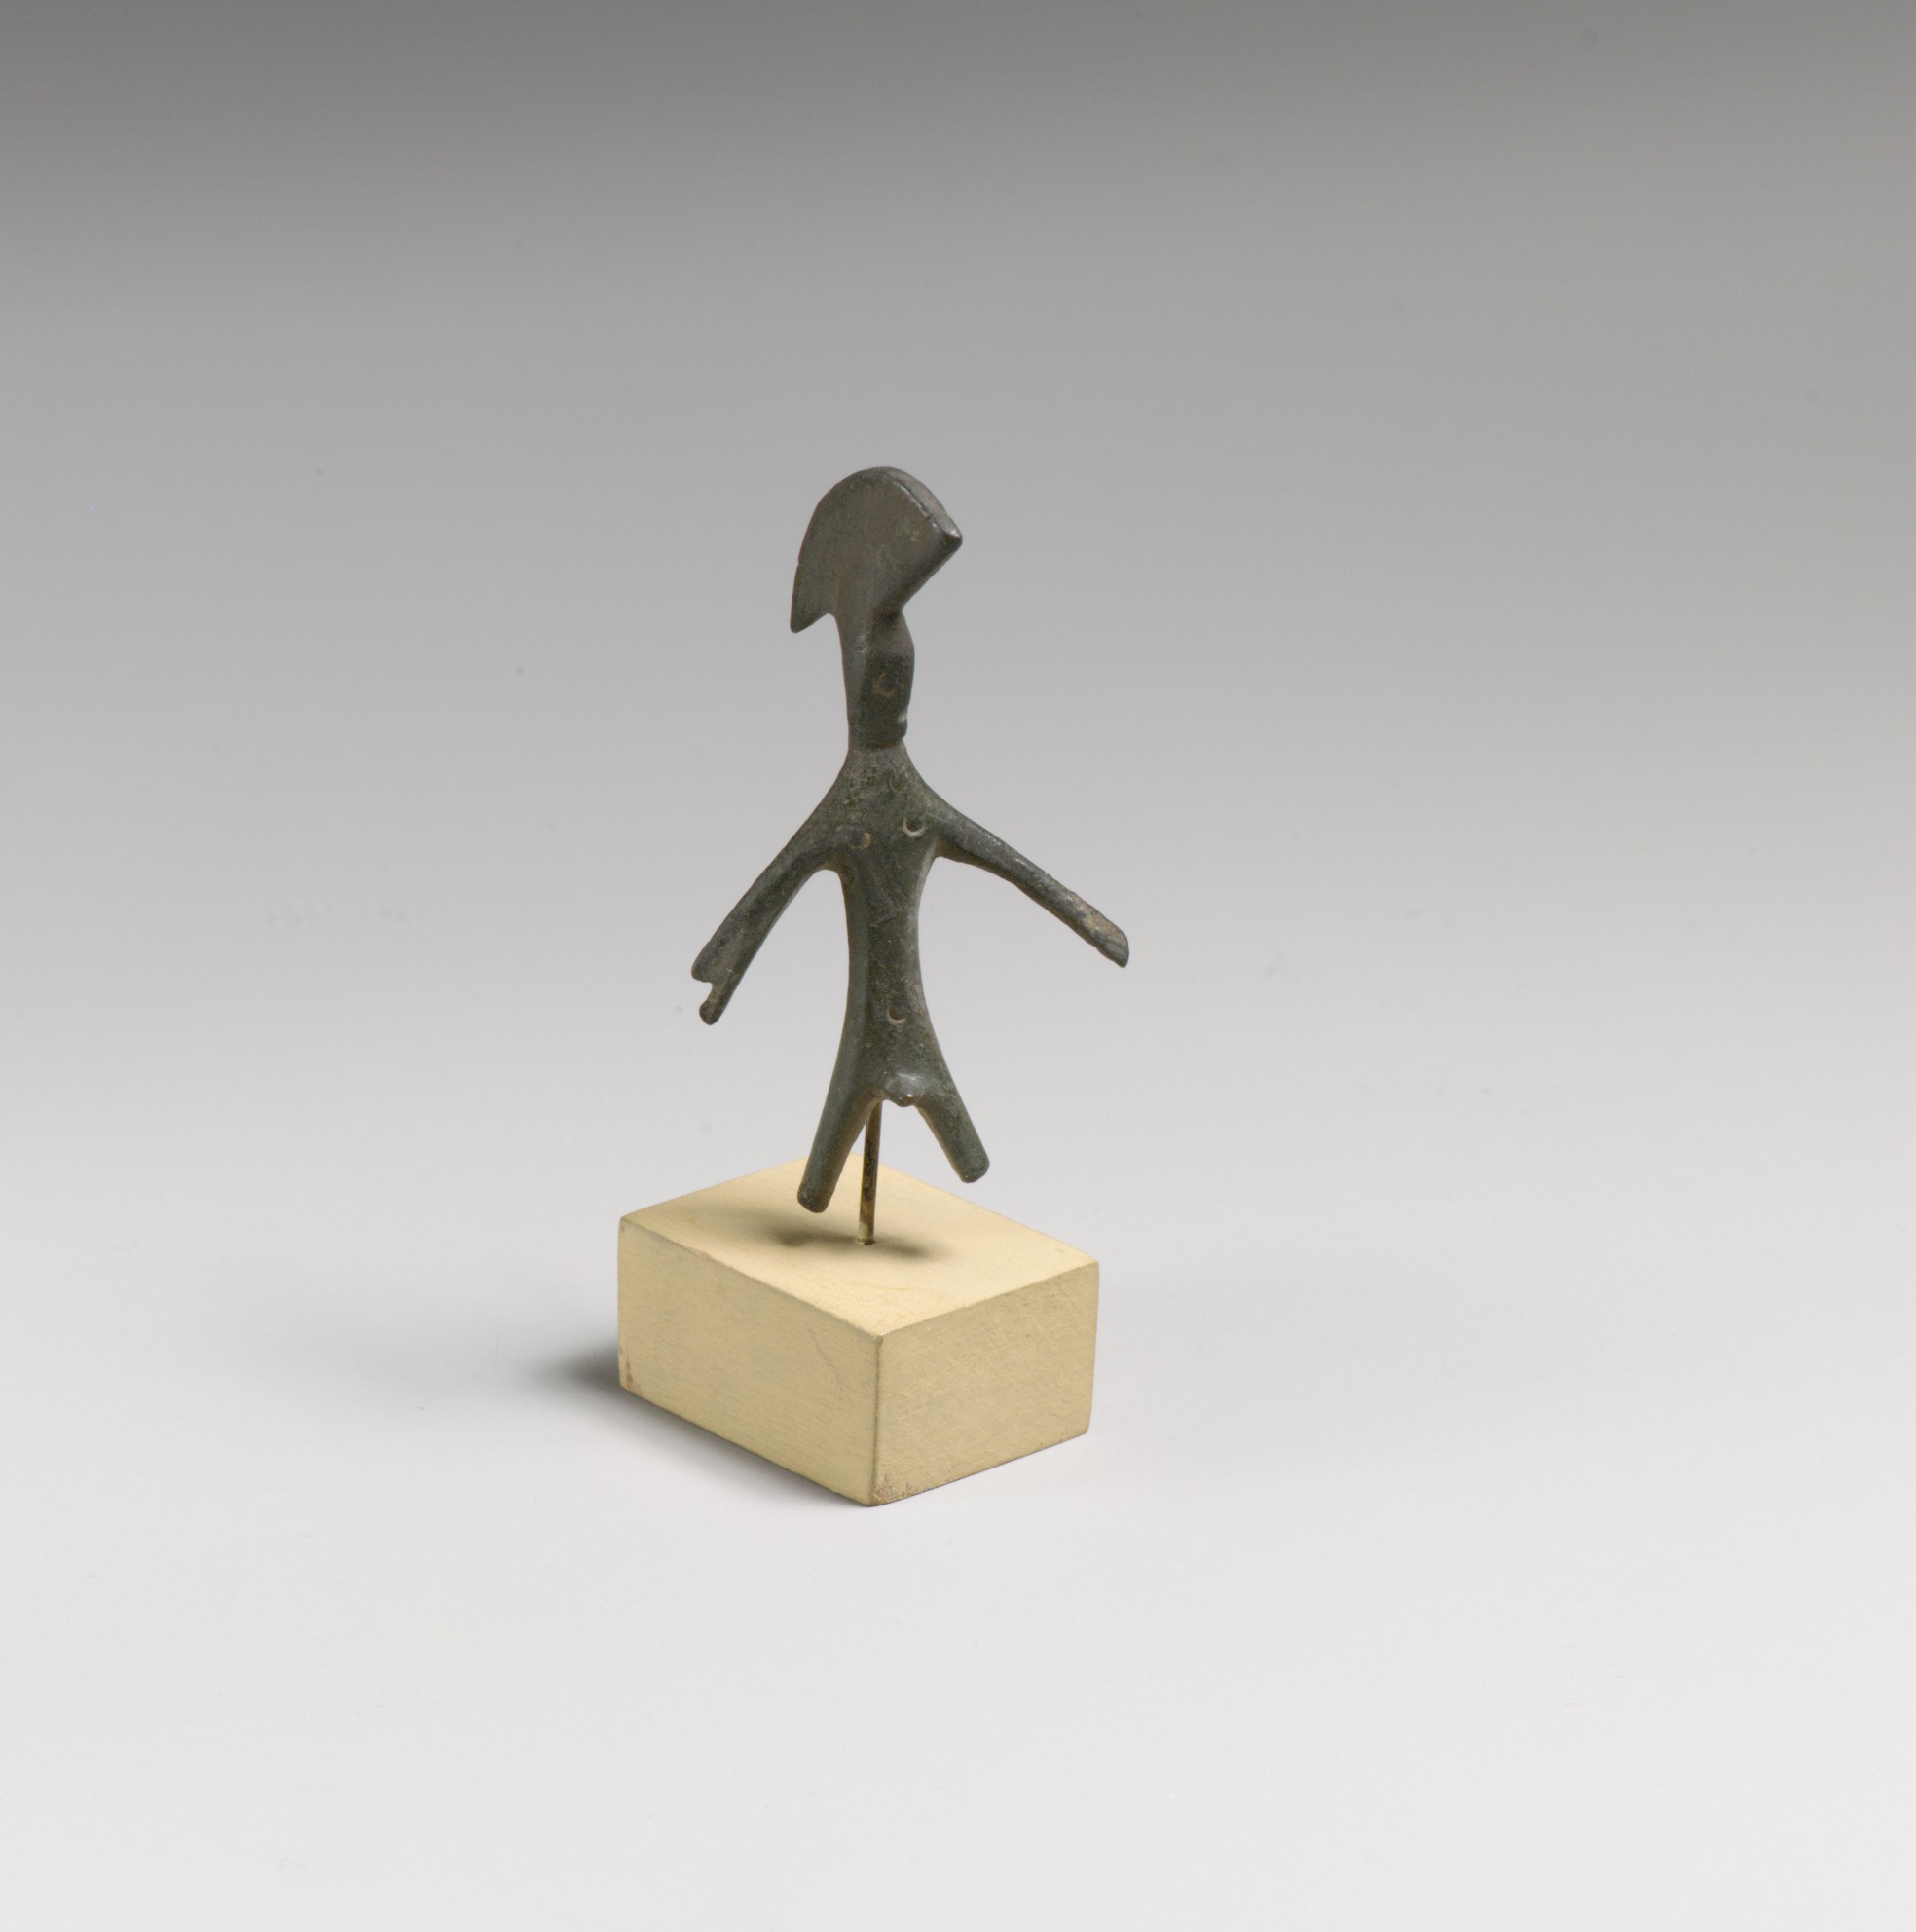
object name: statuette of a warrior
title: Statuette of striding warrior (Ares?)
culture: etruscan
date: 600-501 BCE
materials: bronze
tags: warriors